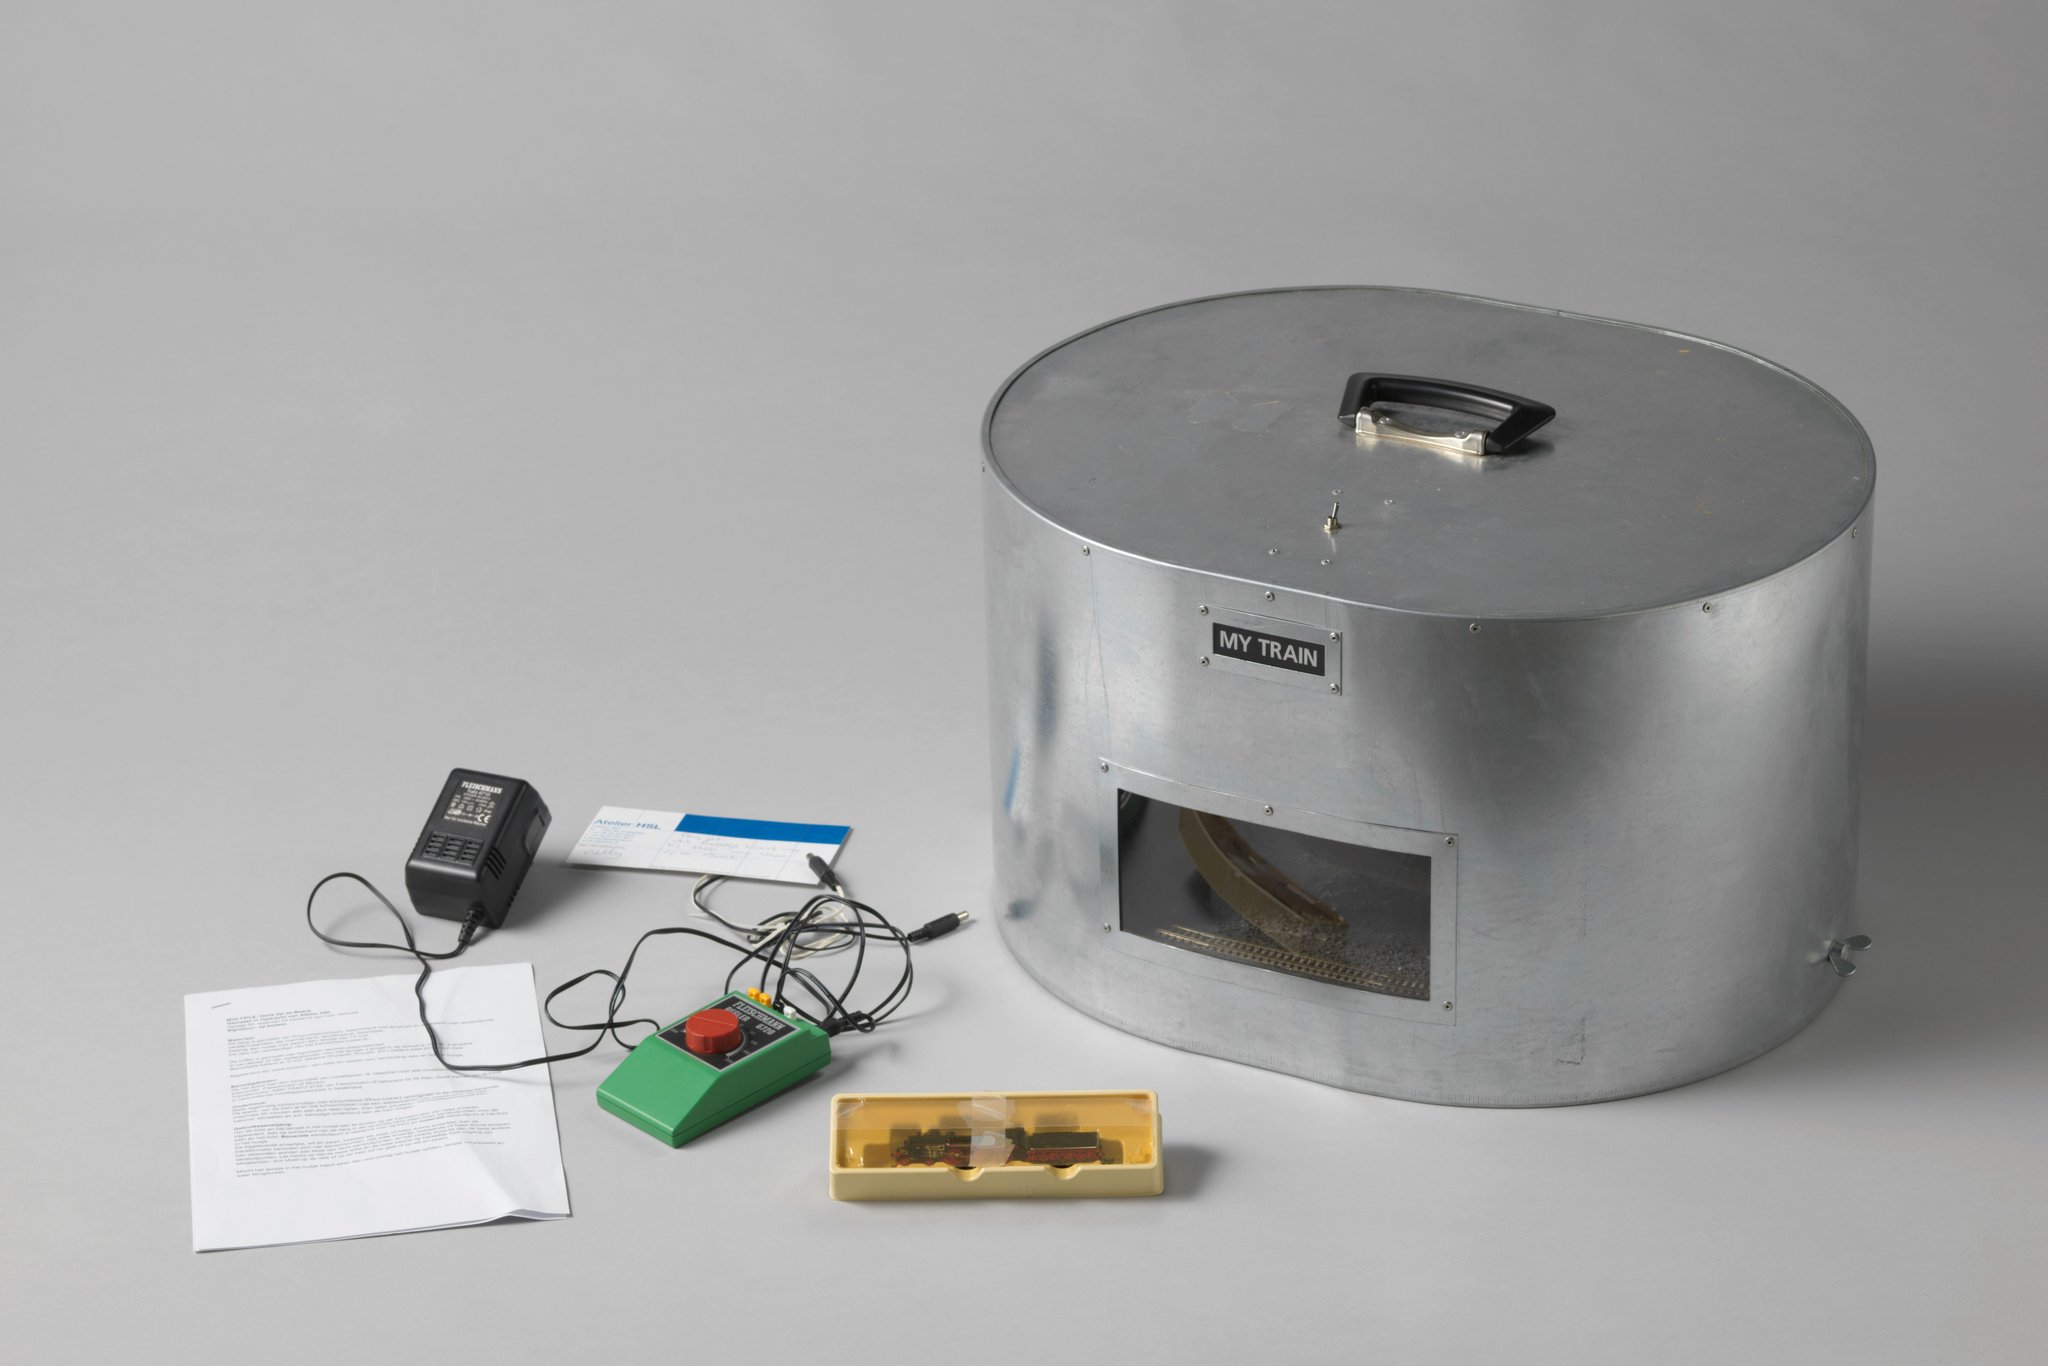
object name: model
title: My train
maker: hans op de beeck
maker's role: installatie-kunstenaar, videokunstenaar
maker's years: 1969-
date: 2002-2003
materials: aluminum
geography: netherlands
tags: netherlands, france, belgium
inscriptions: : ‘My train’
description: Zilverkleurige "Beautycase" van aluminium voor over draagbaar model spoorlandschap geïnspireerd op de Hoge Snelheidslijn van Amsterdam naar Parijs (NG-2008-28-8-B). Met opschrift. Van dit definitieve ontwerp werden 50 exemplaren gemaakt. Gemaakt in opdracht van Atelier HSL.